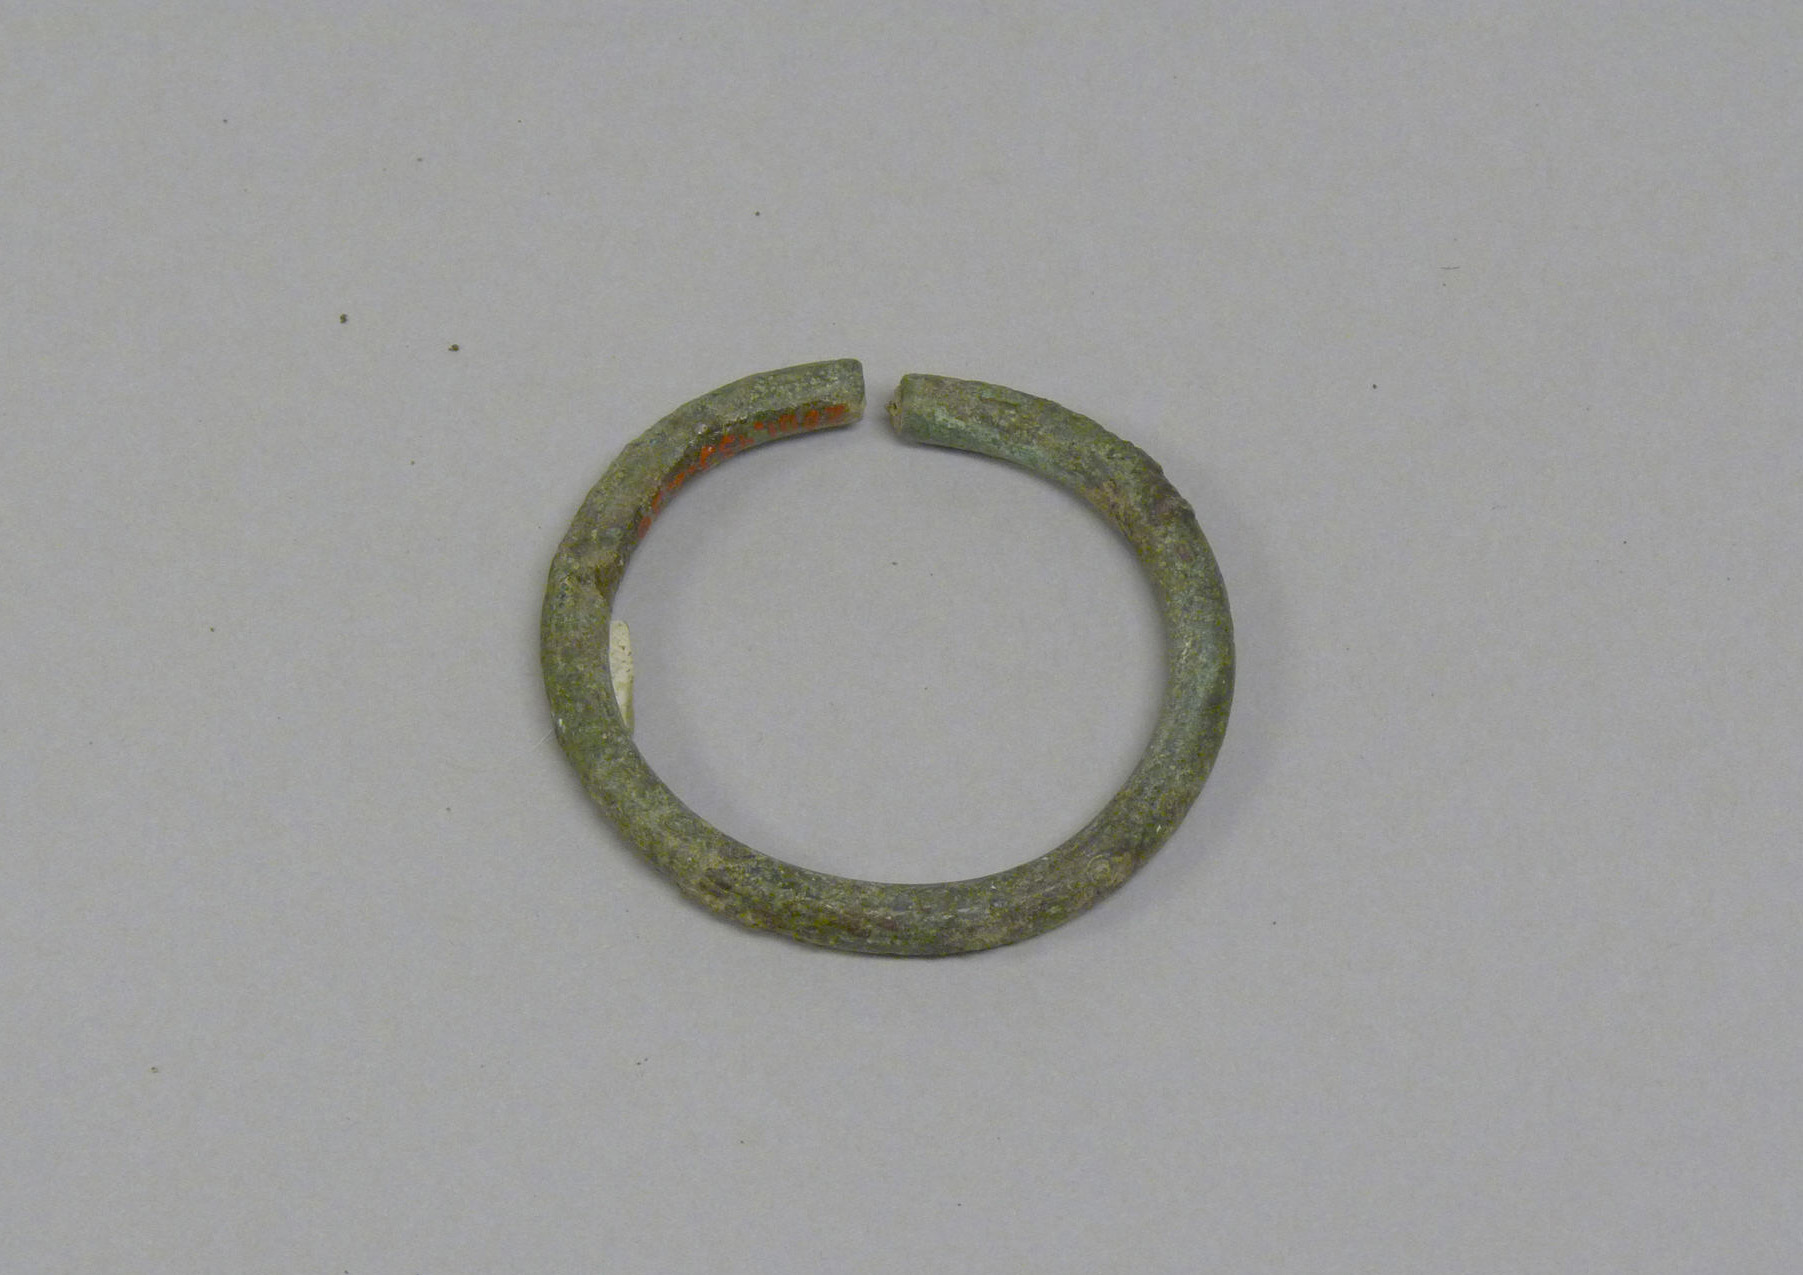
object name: bangle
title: One from a Pair of Solid Undecorated Bangles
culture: thai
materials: bronze